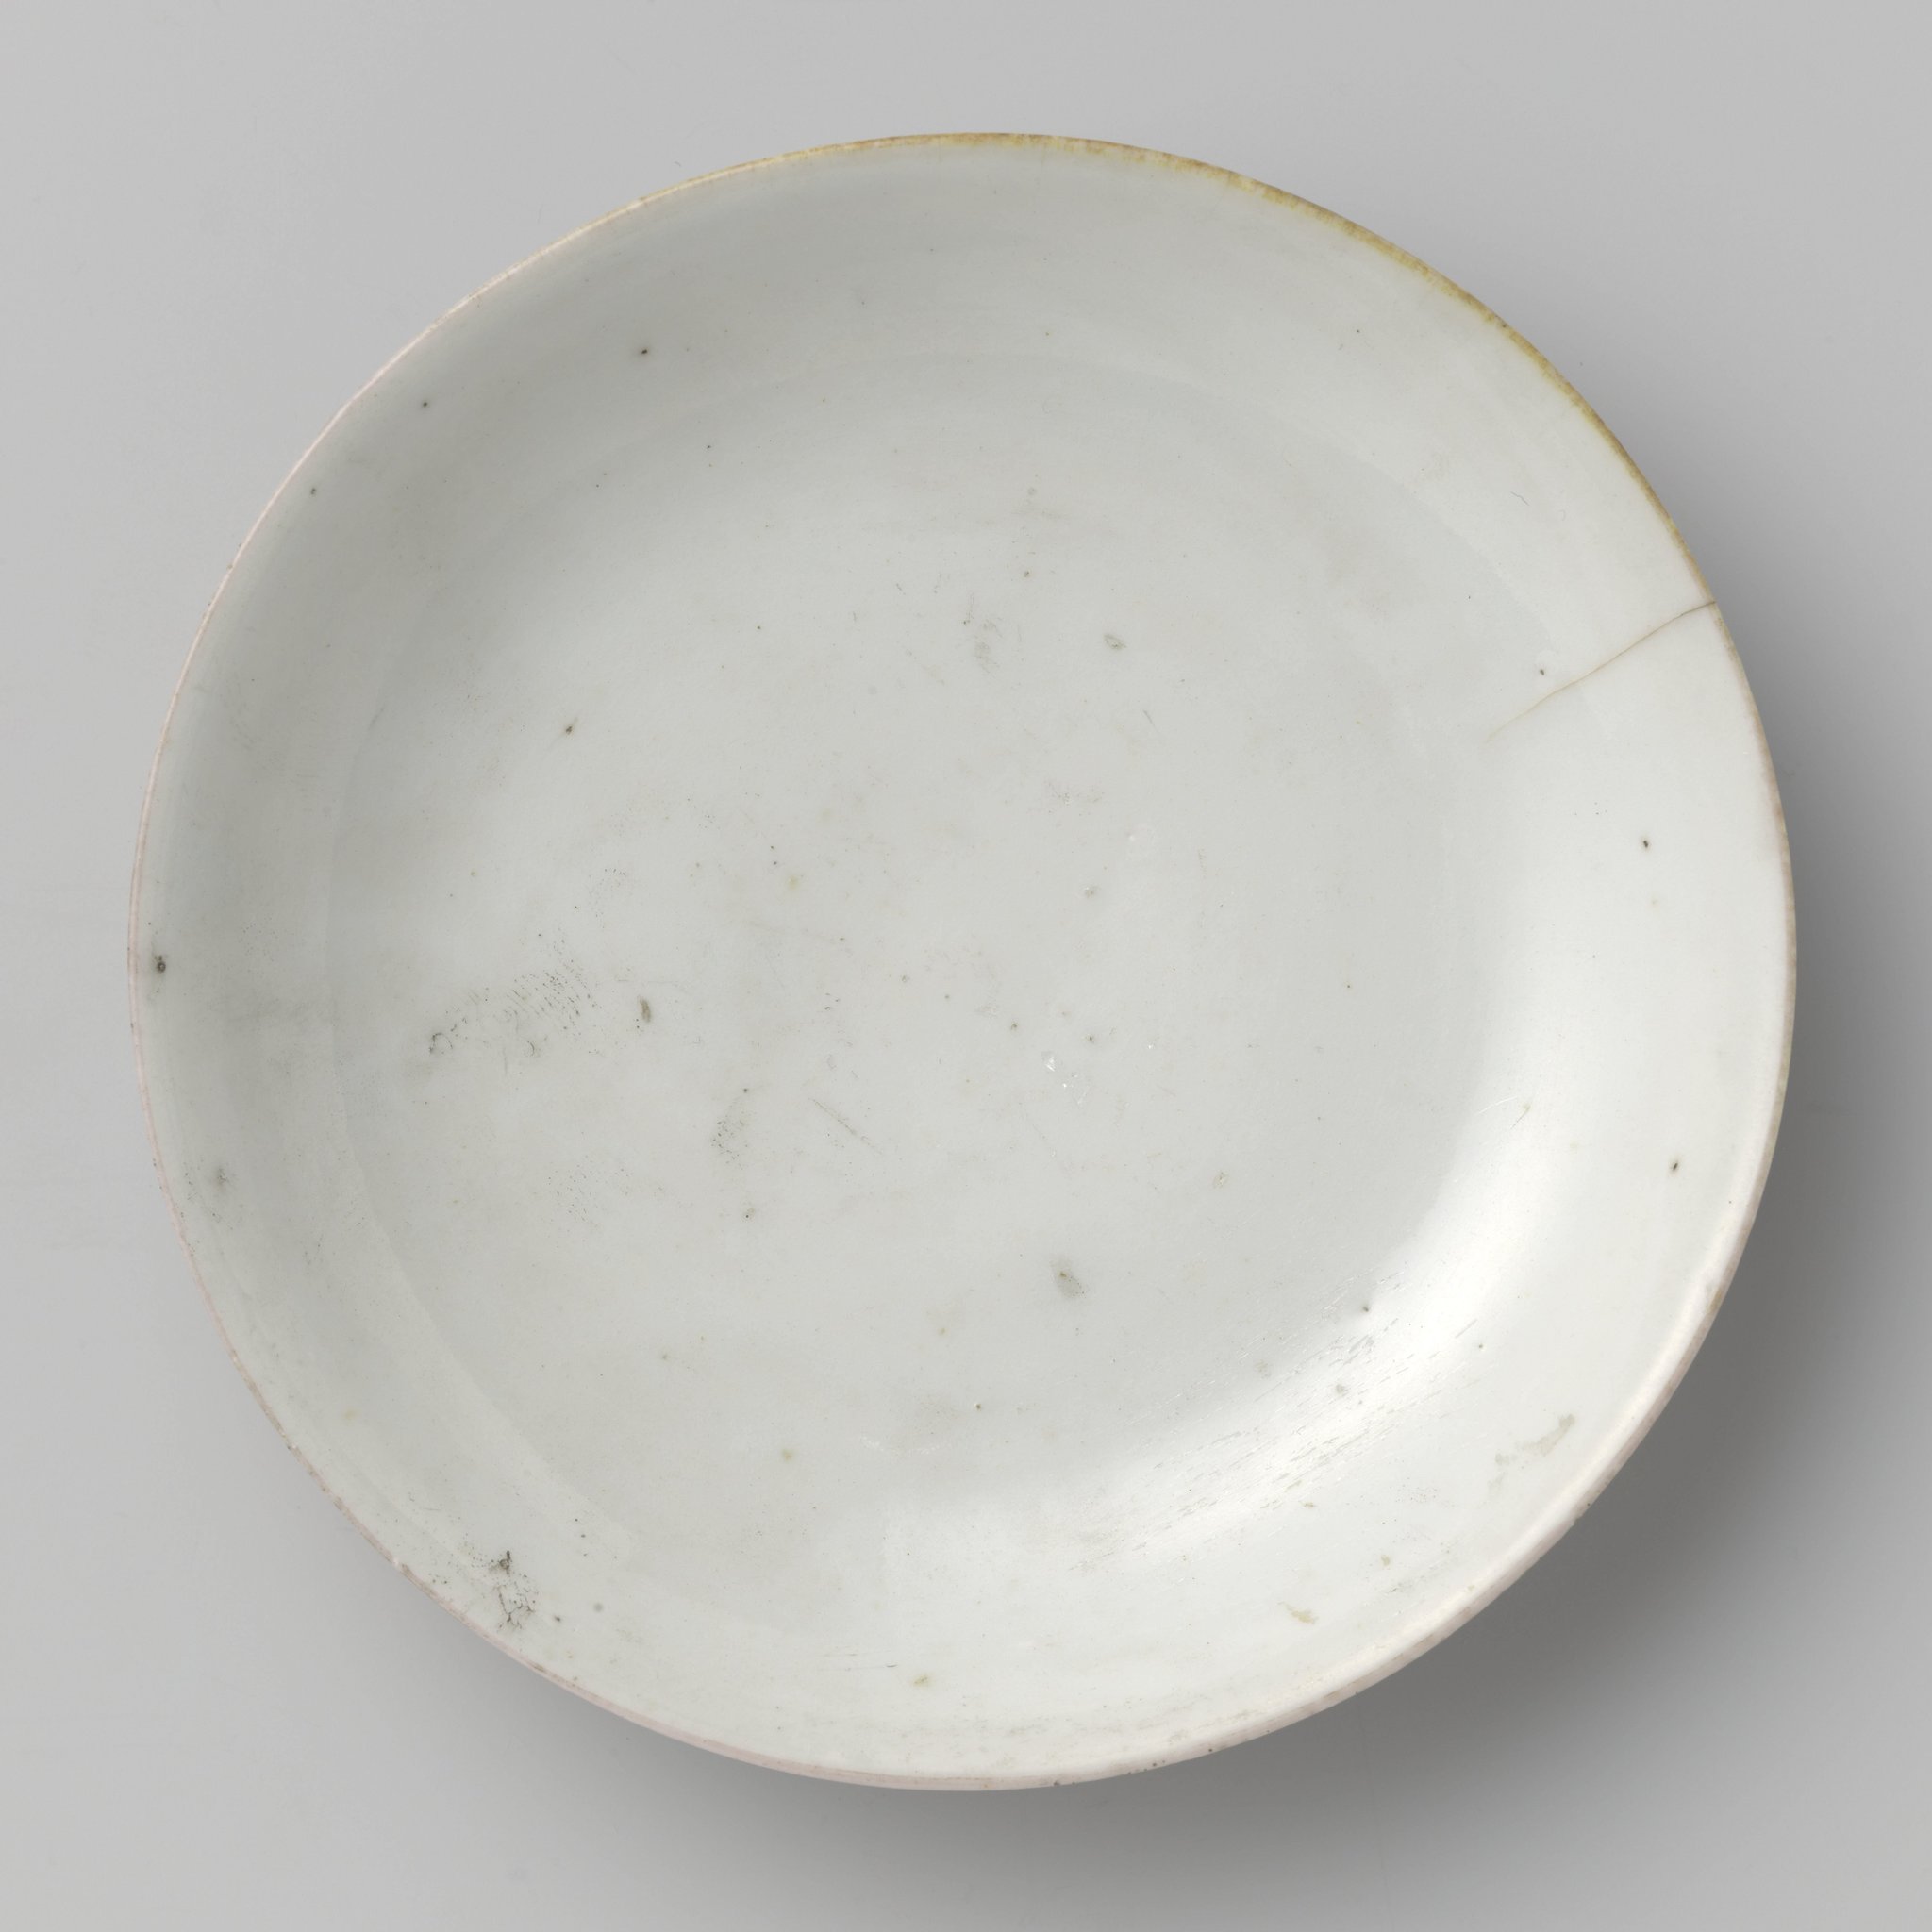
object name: kop en schotel, kop en schotel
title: Saucer with flower sprays on a black ground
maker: Anonymous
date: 1700-1724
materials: cobalt, glaze, paint, porcelain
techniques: firing, turning, vitrification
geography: china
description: Schotel van porselein, beschilderd op het glazuur in rood, aubergine, zwart en goud. Op de buitenzijde bloemtakken tegen een zwarte grond. Het zwart mogelijk in Europa toegevoegd. Een barst in de rand van de schotel. Famille noire.